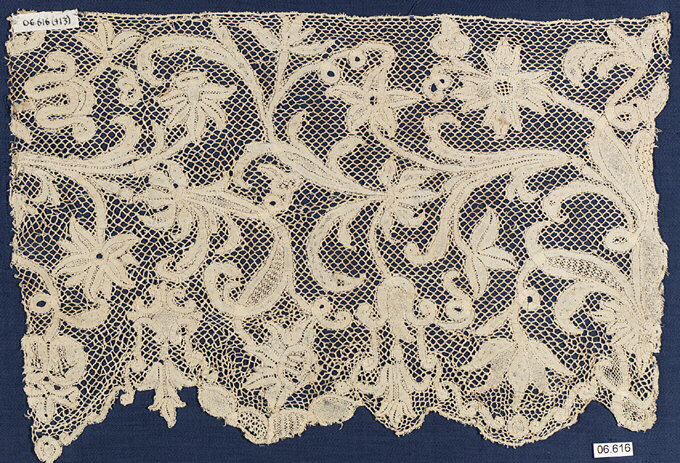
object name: fragment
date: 1701-1733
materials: lace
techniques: lace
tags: flowers,leaves